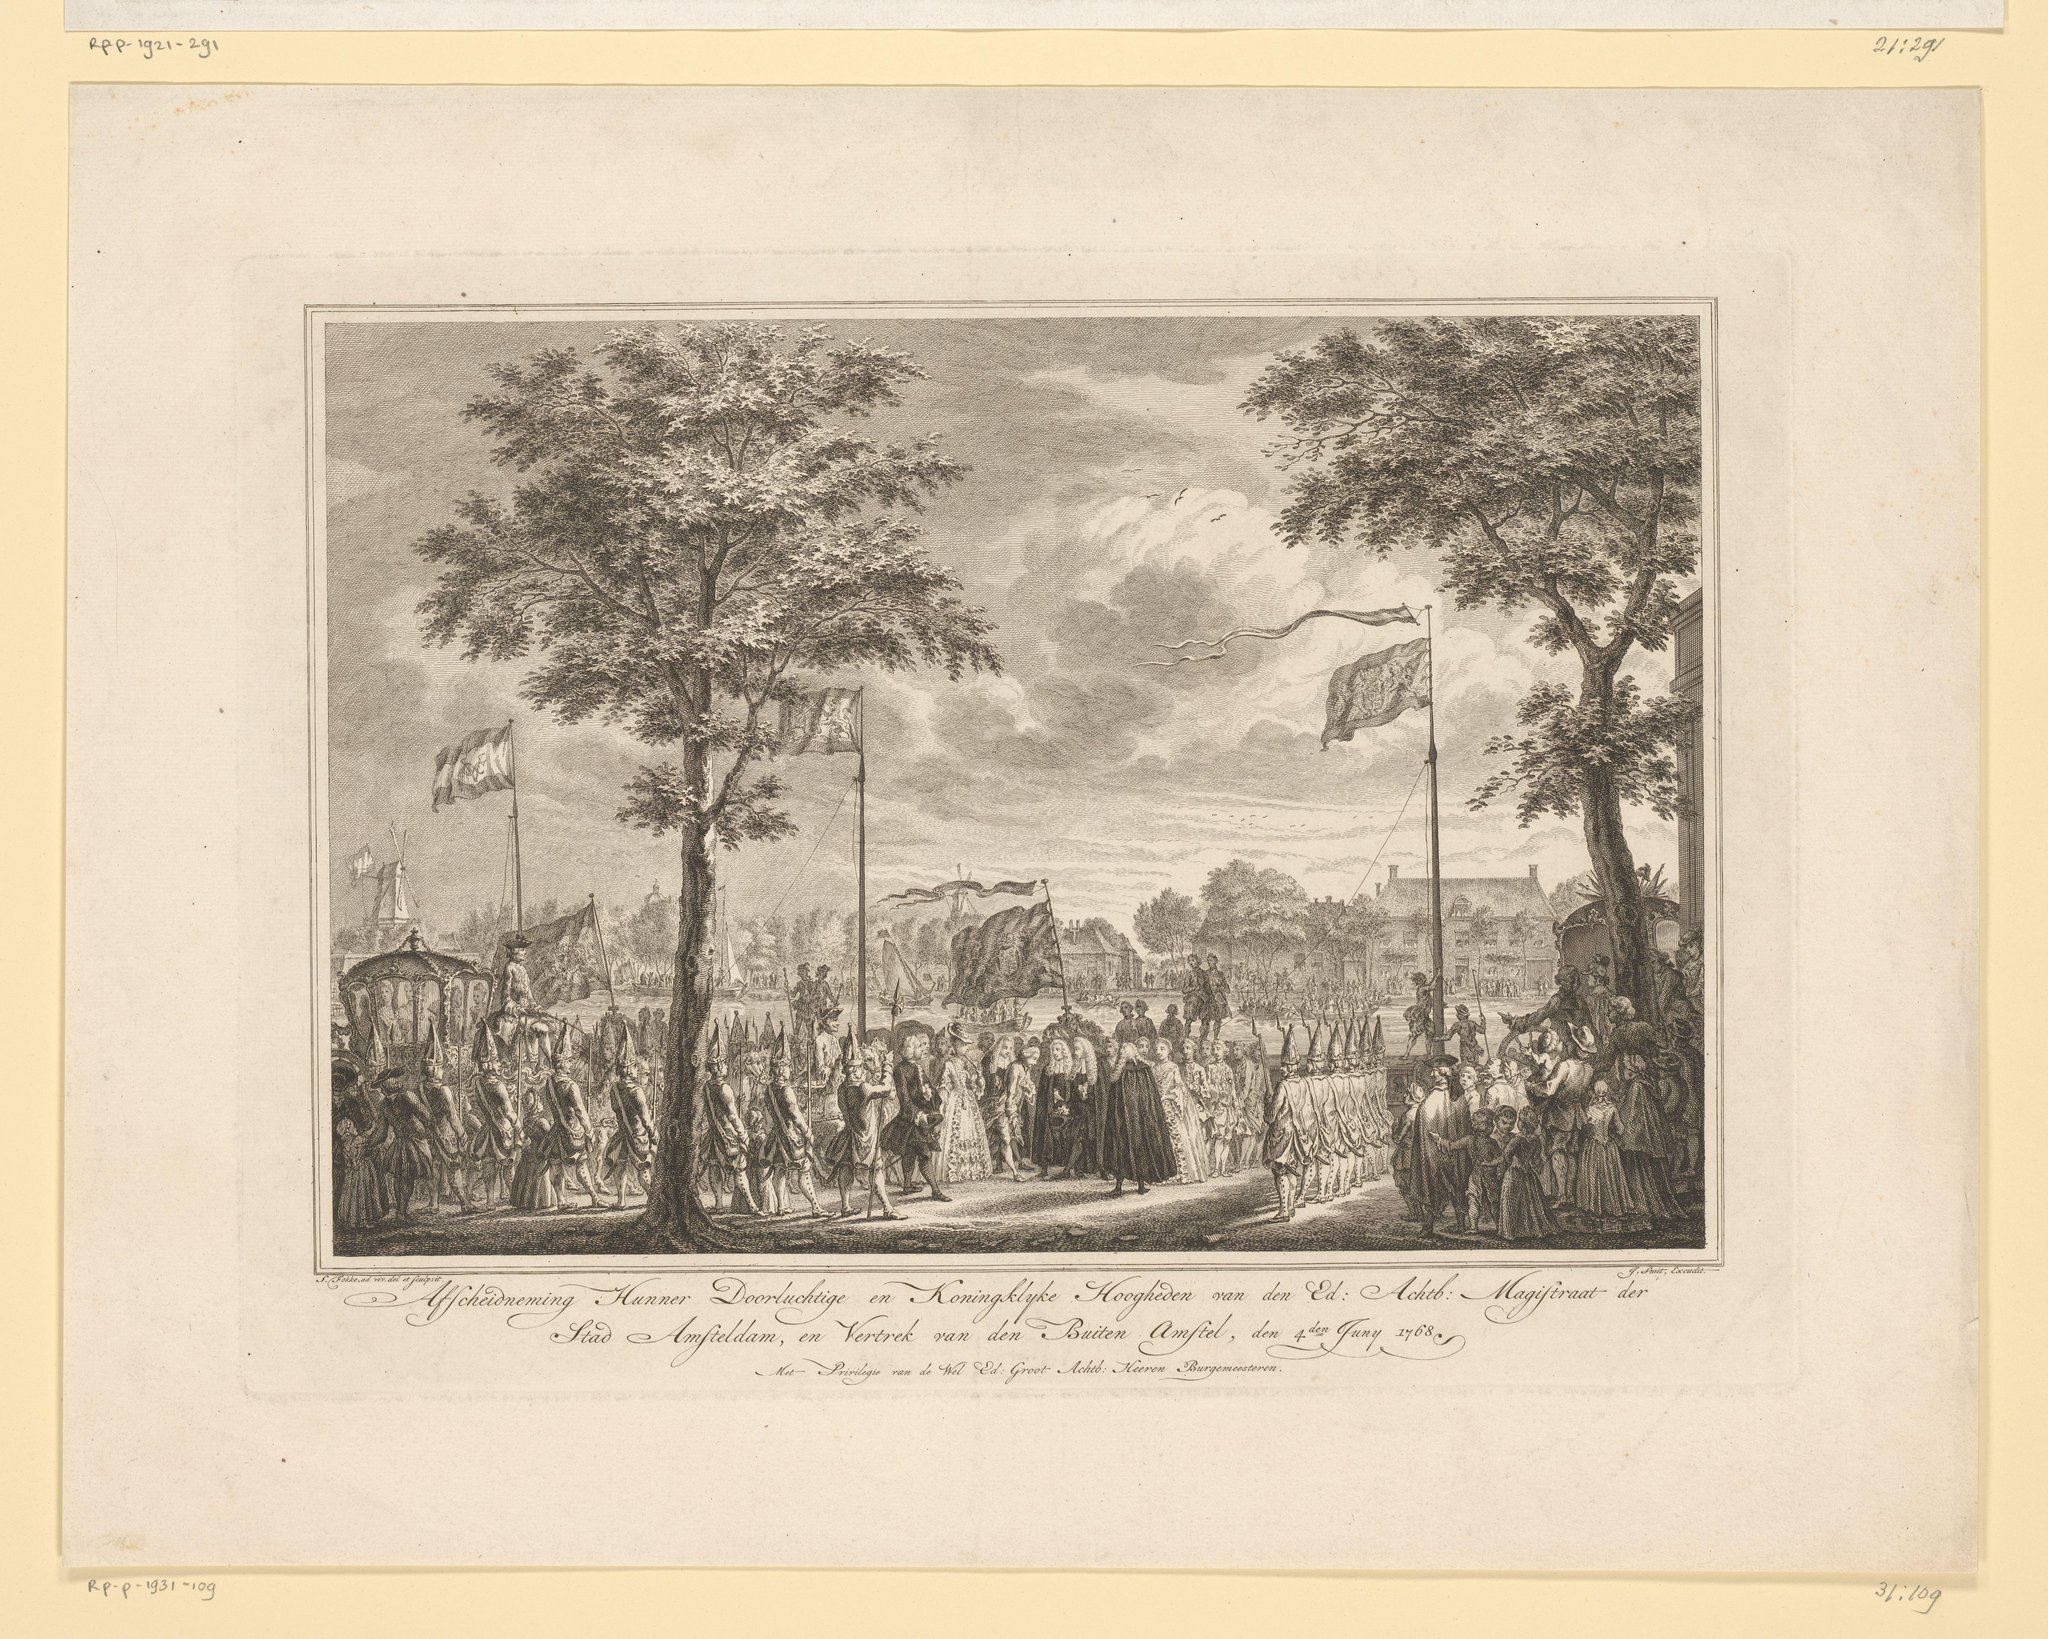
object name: print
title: Afscheid van Willem V en echtgenote aan de Buiten Amstel, 1768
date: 1769-1773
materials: paper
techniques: engraving, etching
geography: northern netherlands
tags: the hague, william v (prince of orange), berlin, painter, draughtsman, wilhelmina of prussia (princess of orange), public festivities on the occasion of royal events, amsterdam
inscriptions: collector's mark: Lugt 2233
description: De stadhouder Willem V en prinses Wilhelmina van Pruisen nemen afscheid van het magistraat van Amsterdam bij de herberg De Berebijt aan de Buiten Amstel, 4 juni 1768. Onderdeel van een prentserie met titelprent en veertien platen van de inhaling van de prins en prinses te Amsterdam, 30 mei - 4 juni 1768.